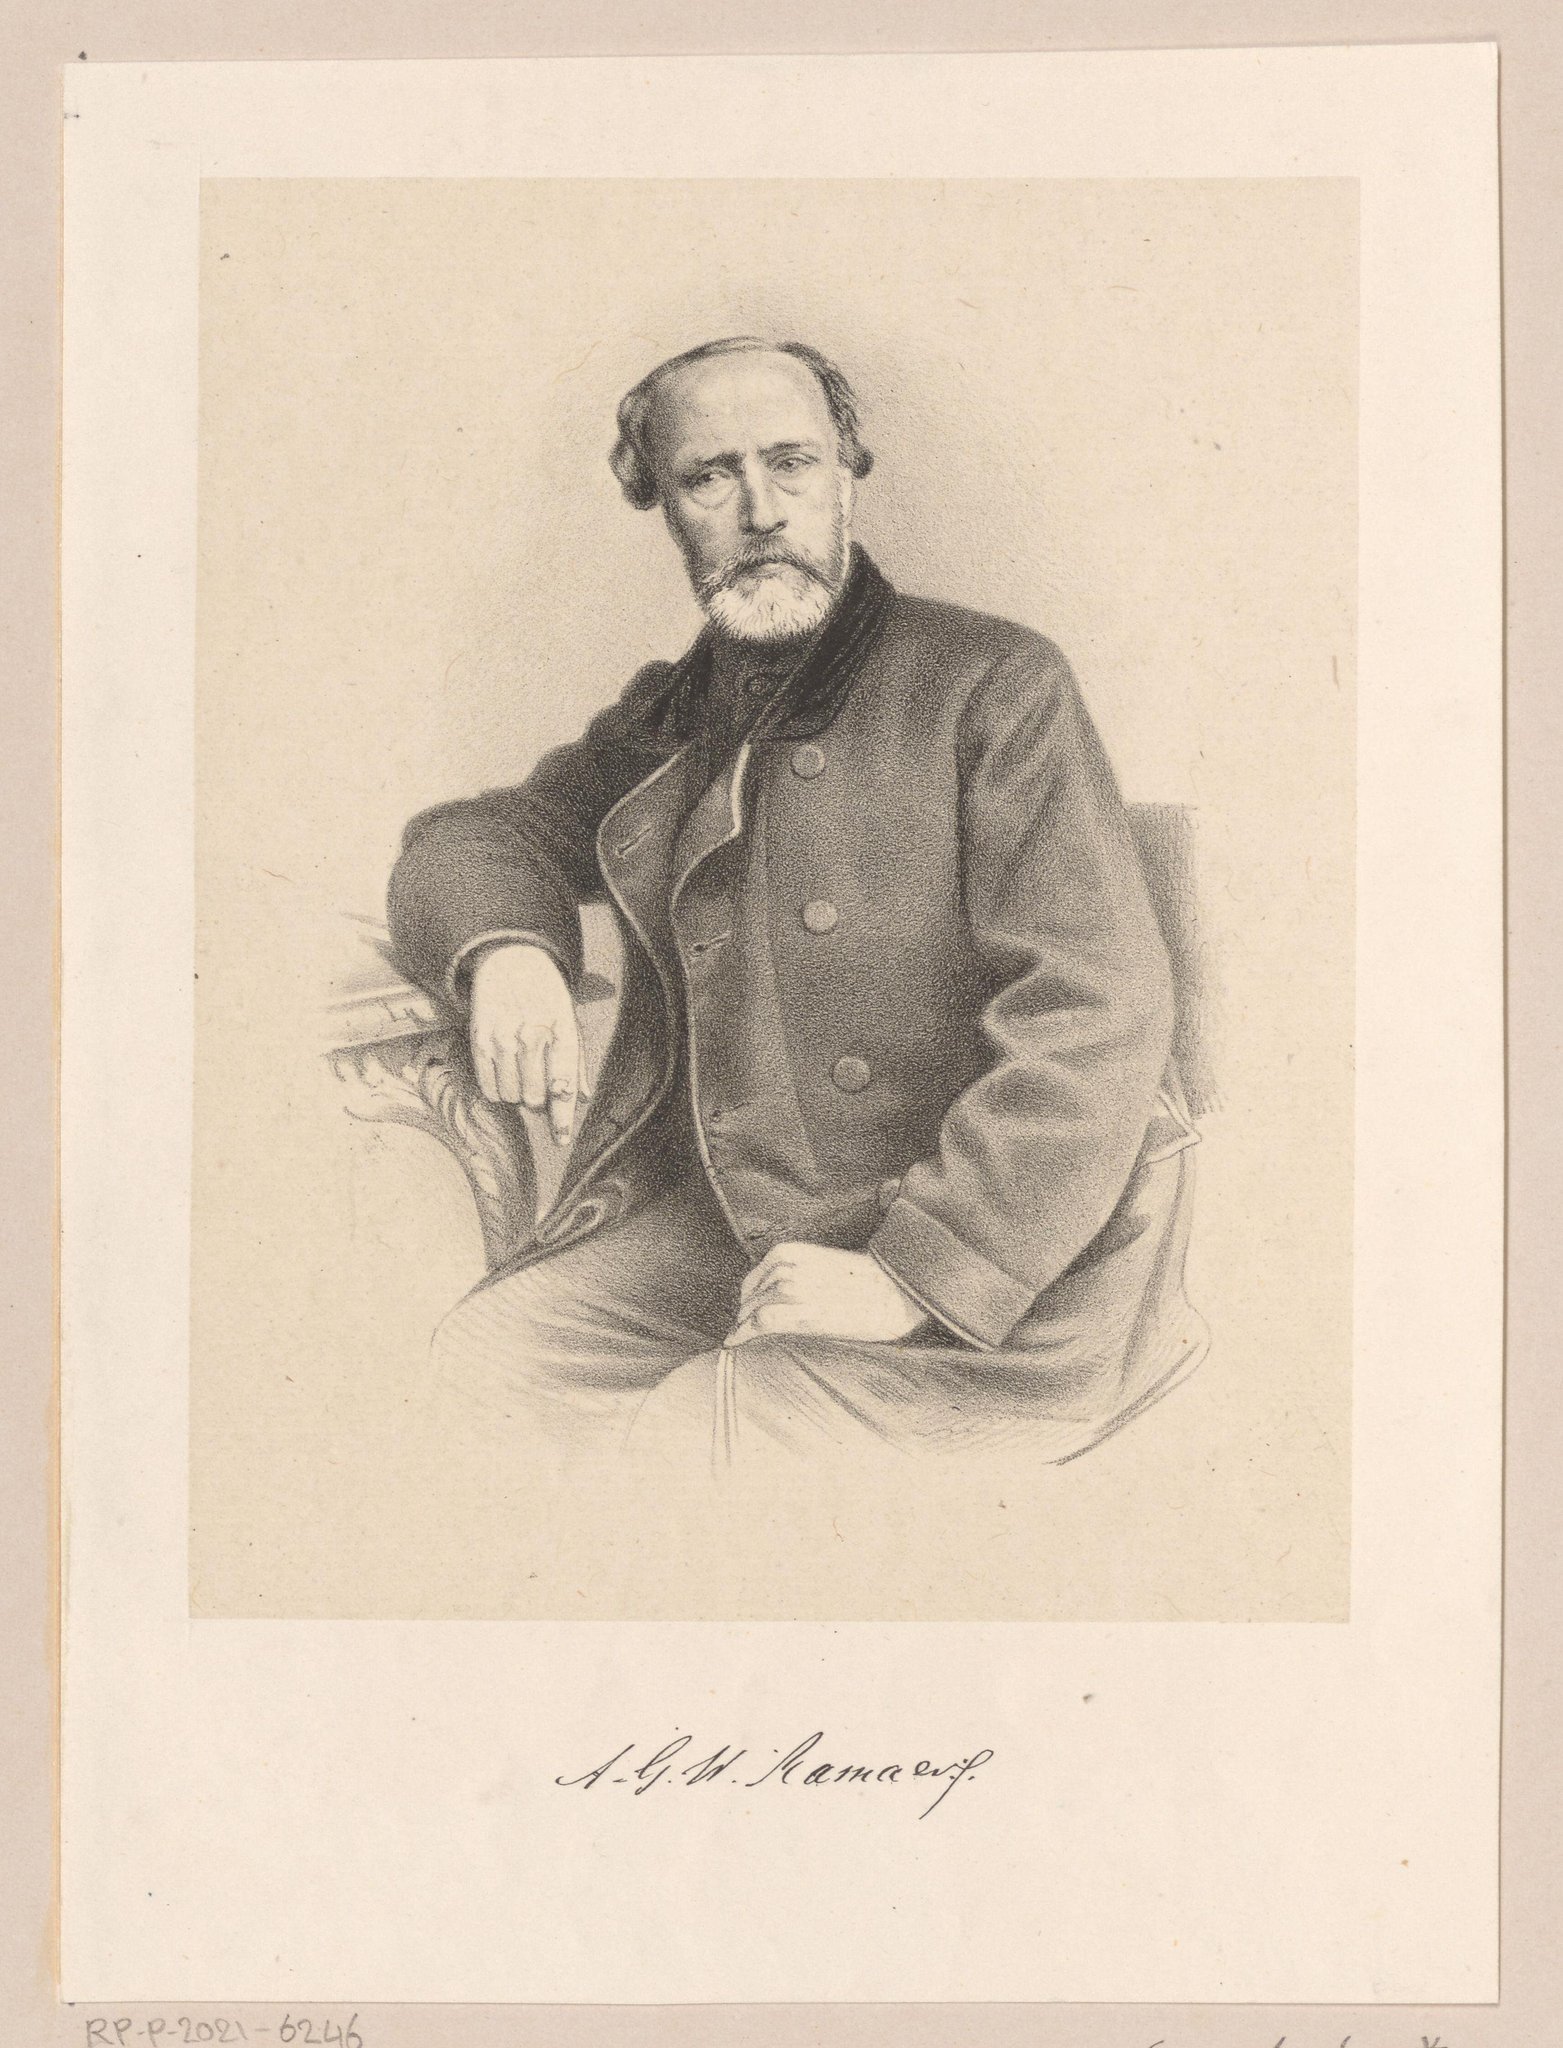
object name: print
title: Portret van Anton Gerhard Wilhelm Ramaer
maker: Anonymous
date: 1842-1899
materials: paper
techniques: lithograph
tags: historical persons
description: Onder het portret een facsimile van de handtekening van de geportretteerde.